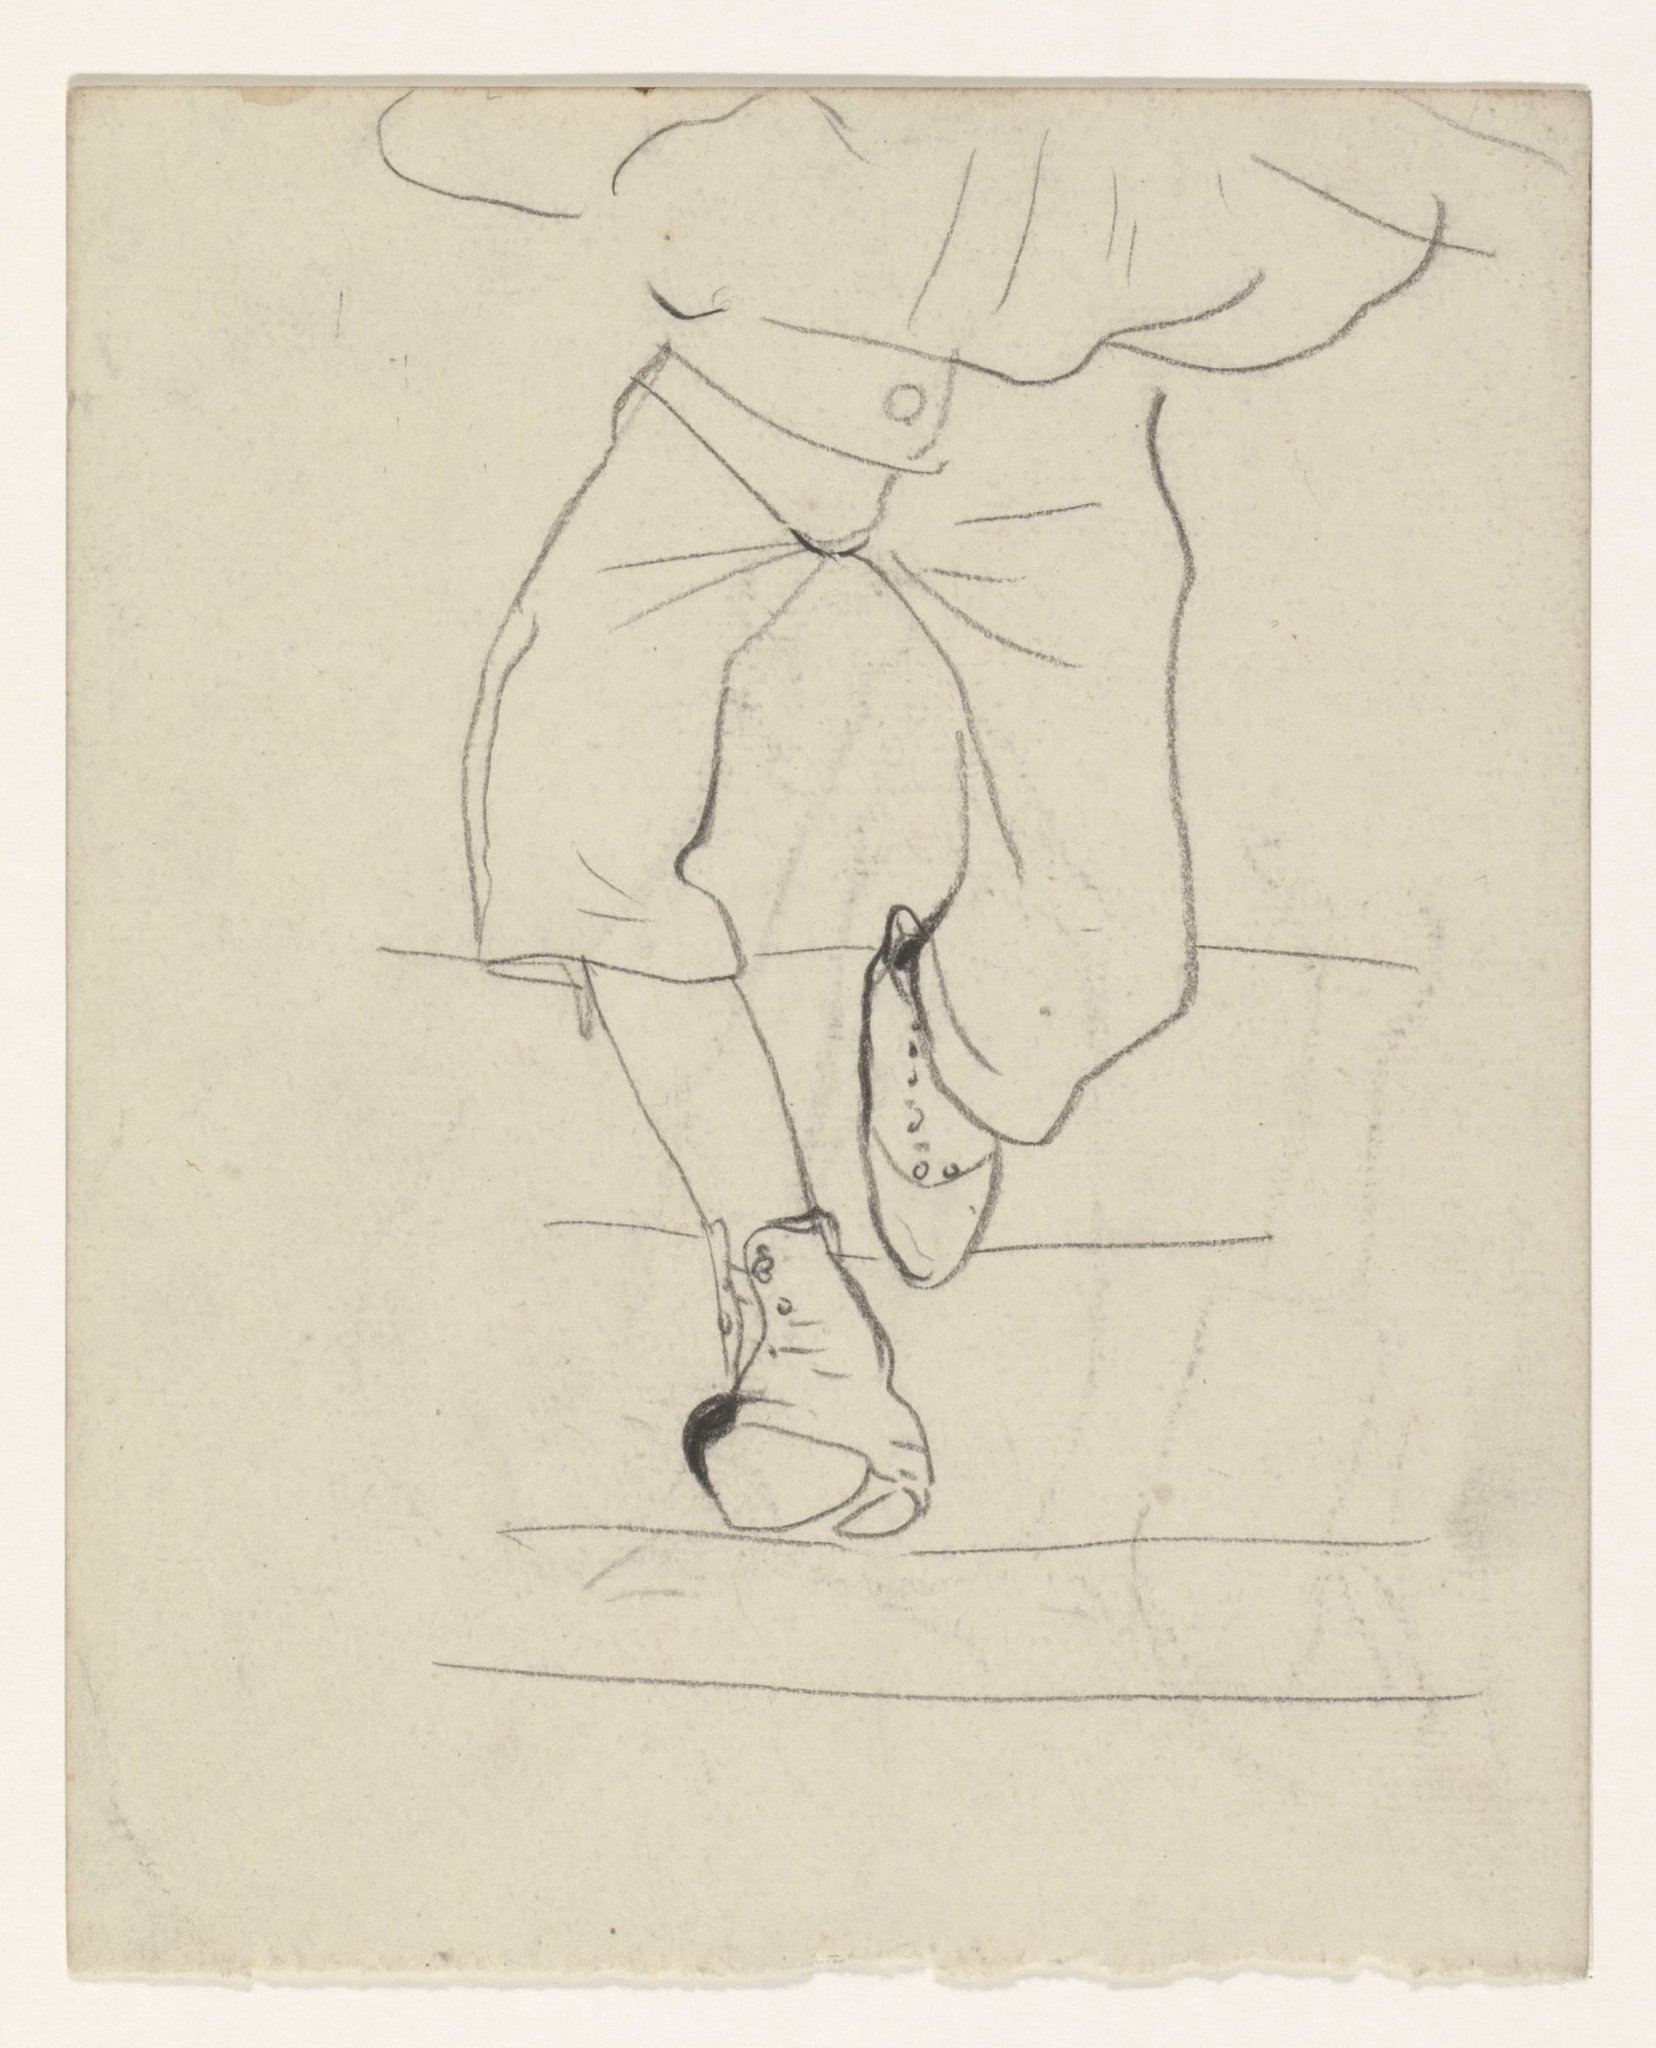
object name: drawing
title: Benen van een lopende jongen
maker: carel adolph lion cachet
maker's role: draughtsman, print maker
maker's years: 1864-1945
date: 1874-1945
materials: chalk, paper